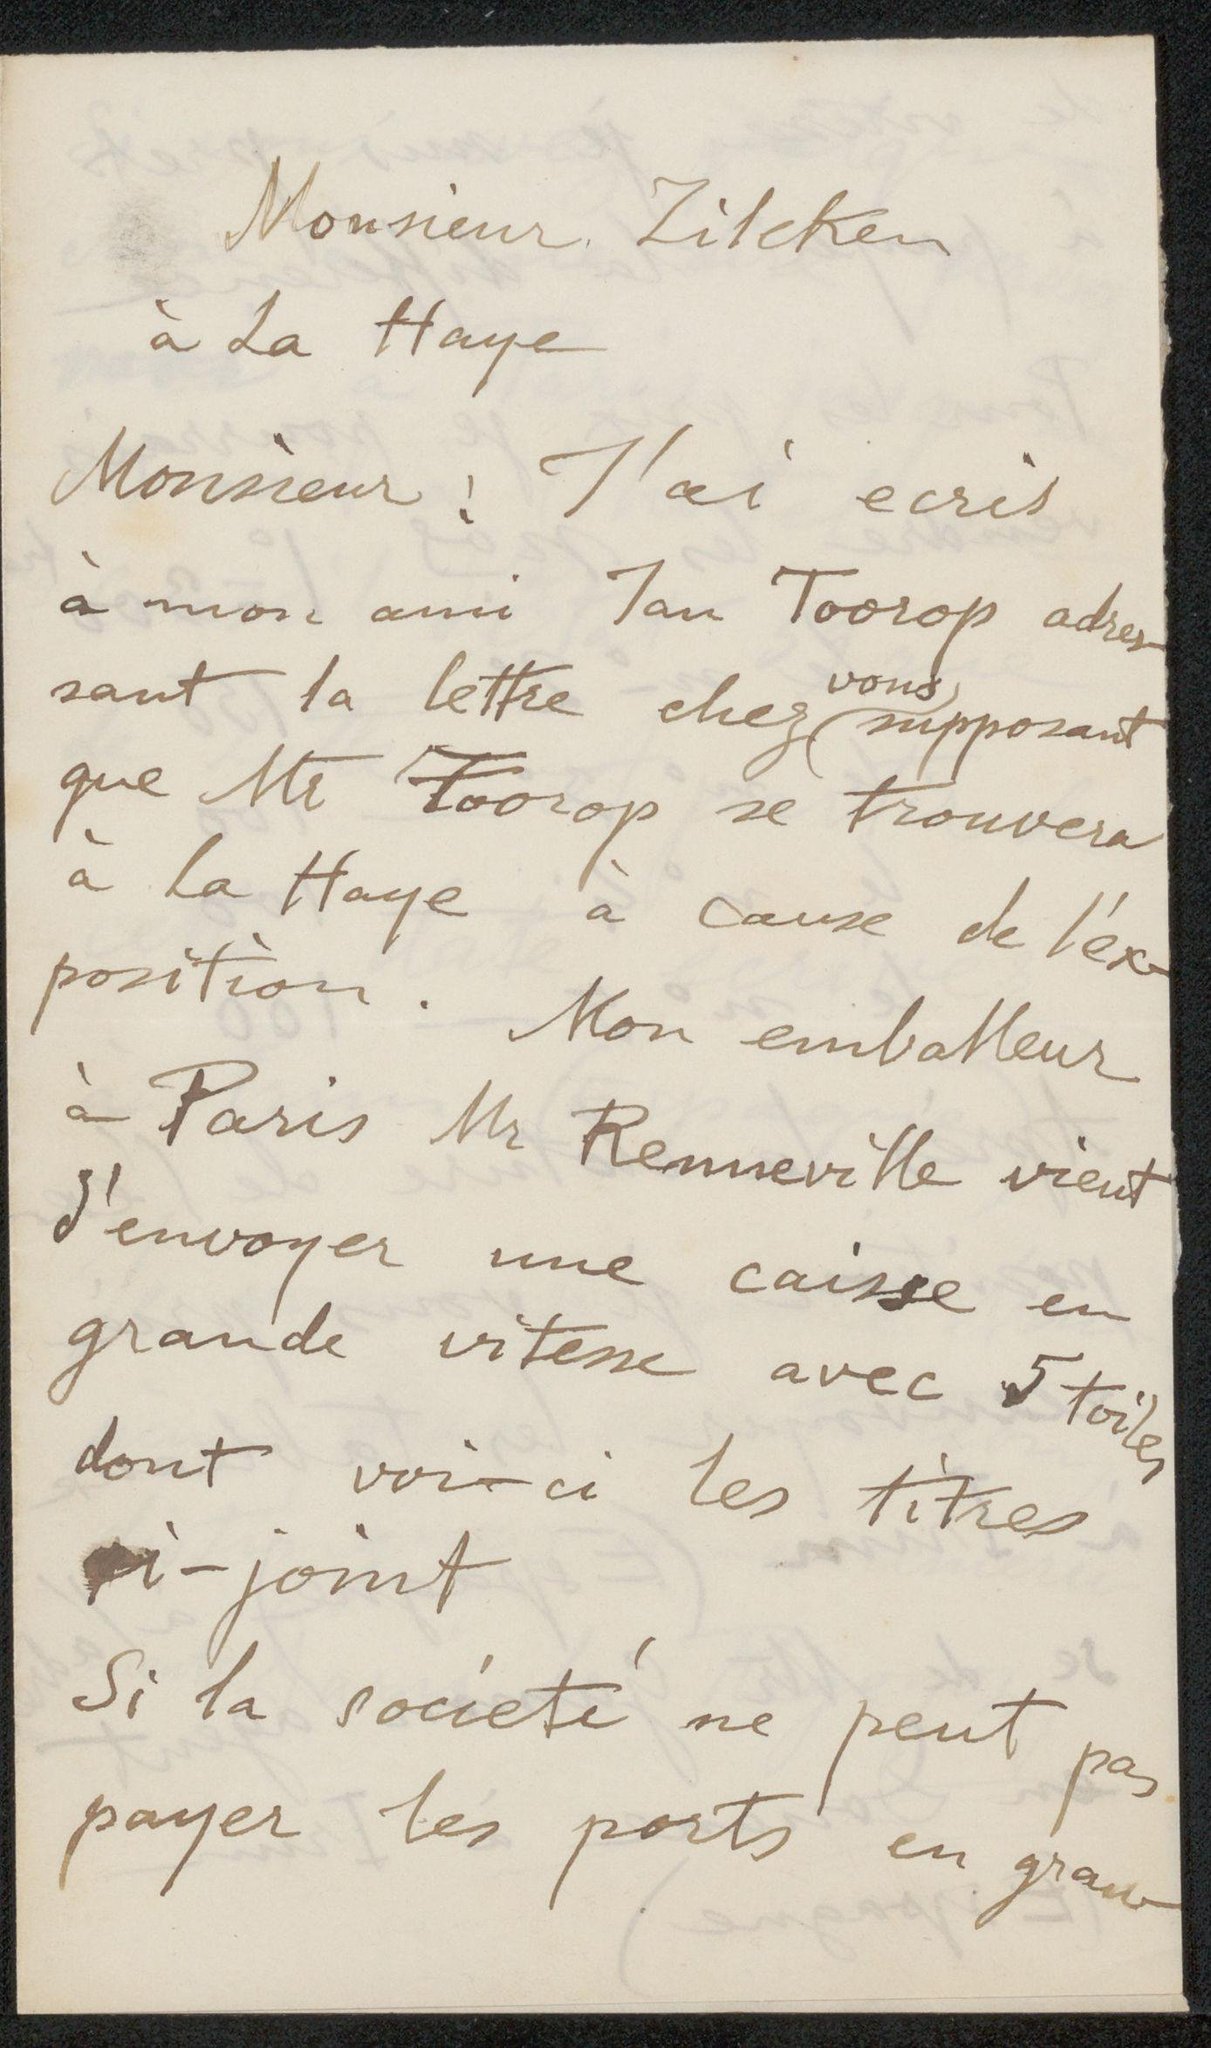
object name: letter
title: Brief aan Philip Zilcken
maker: darío de regoyos y valdés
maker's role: painter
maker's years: 1857-1913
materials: ink, paper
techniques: pen, writing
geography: paris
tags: the hague, painter, print maker, draughtsman, jan toorop, philip zilcken, painting (including book-illumination, miniature-painting), exhibition ~ art, money, paris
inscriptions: collector's mark: ‘RPK’